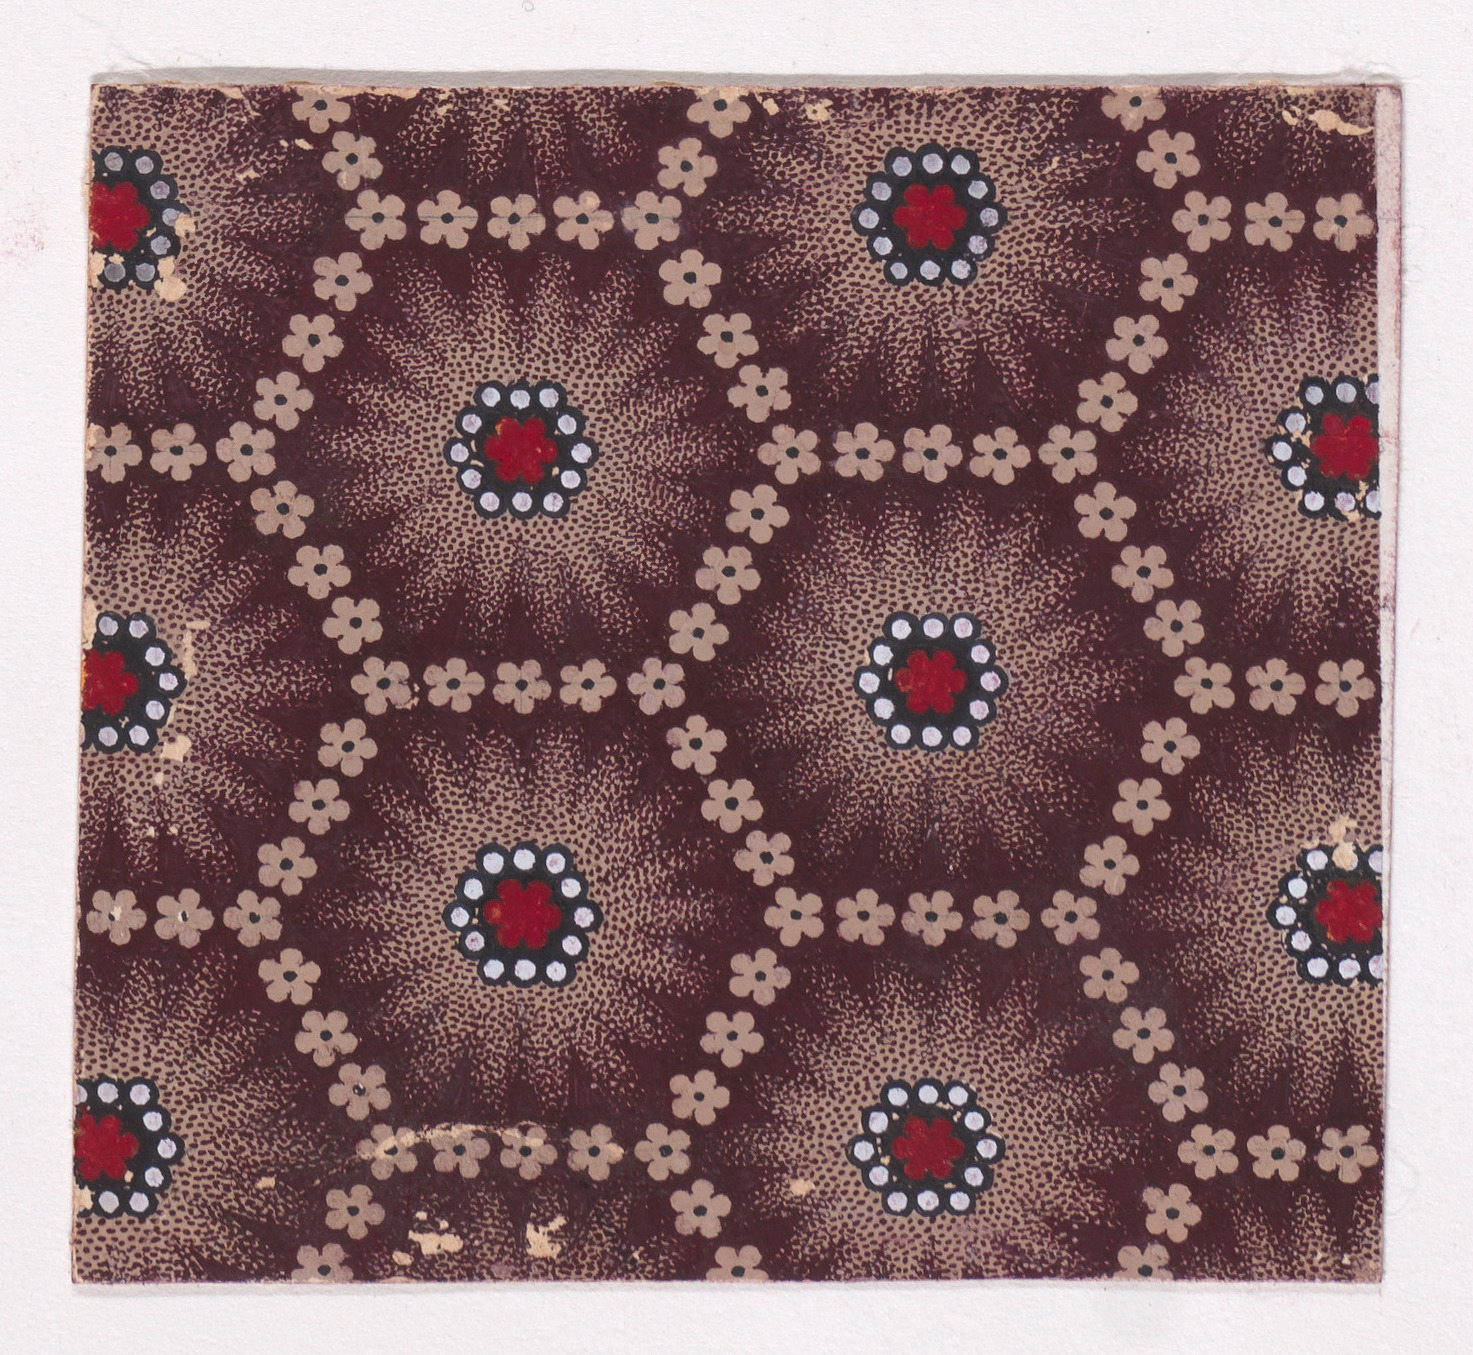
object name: drawing ornament architecture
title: Textile Design with a Honeycomb Pattern Formed with Small Rosettes and with Alternating Rows of Rosettes Framed by Pearls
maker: anonymous, alsatian, 19th century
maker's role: artist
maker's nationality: alsatian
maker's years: 1800-1900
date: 1840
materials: gouache